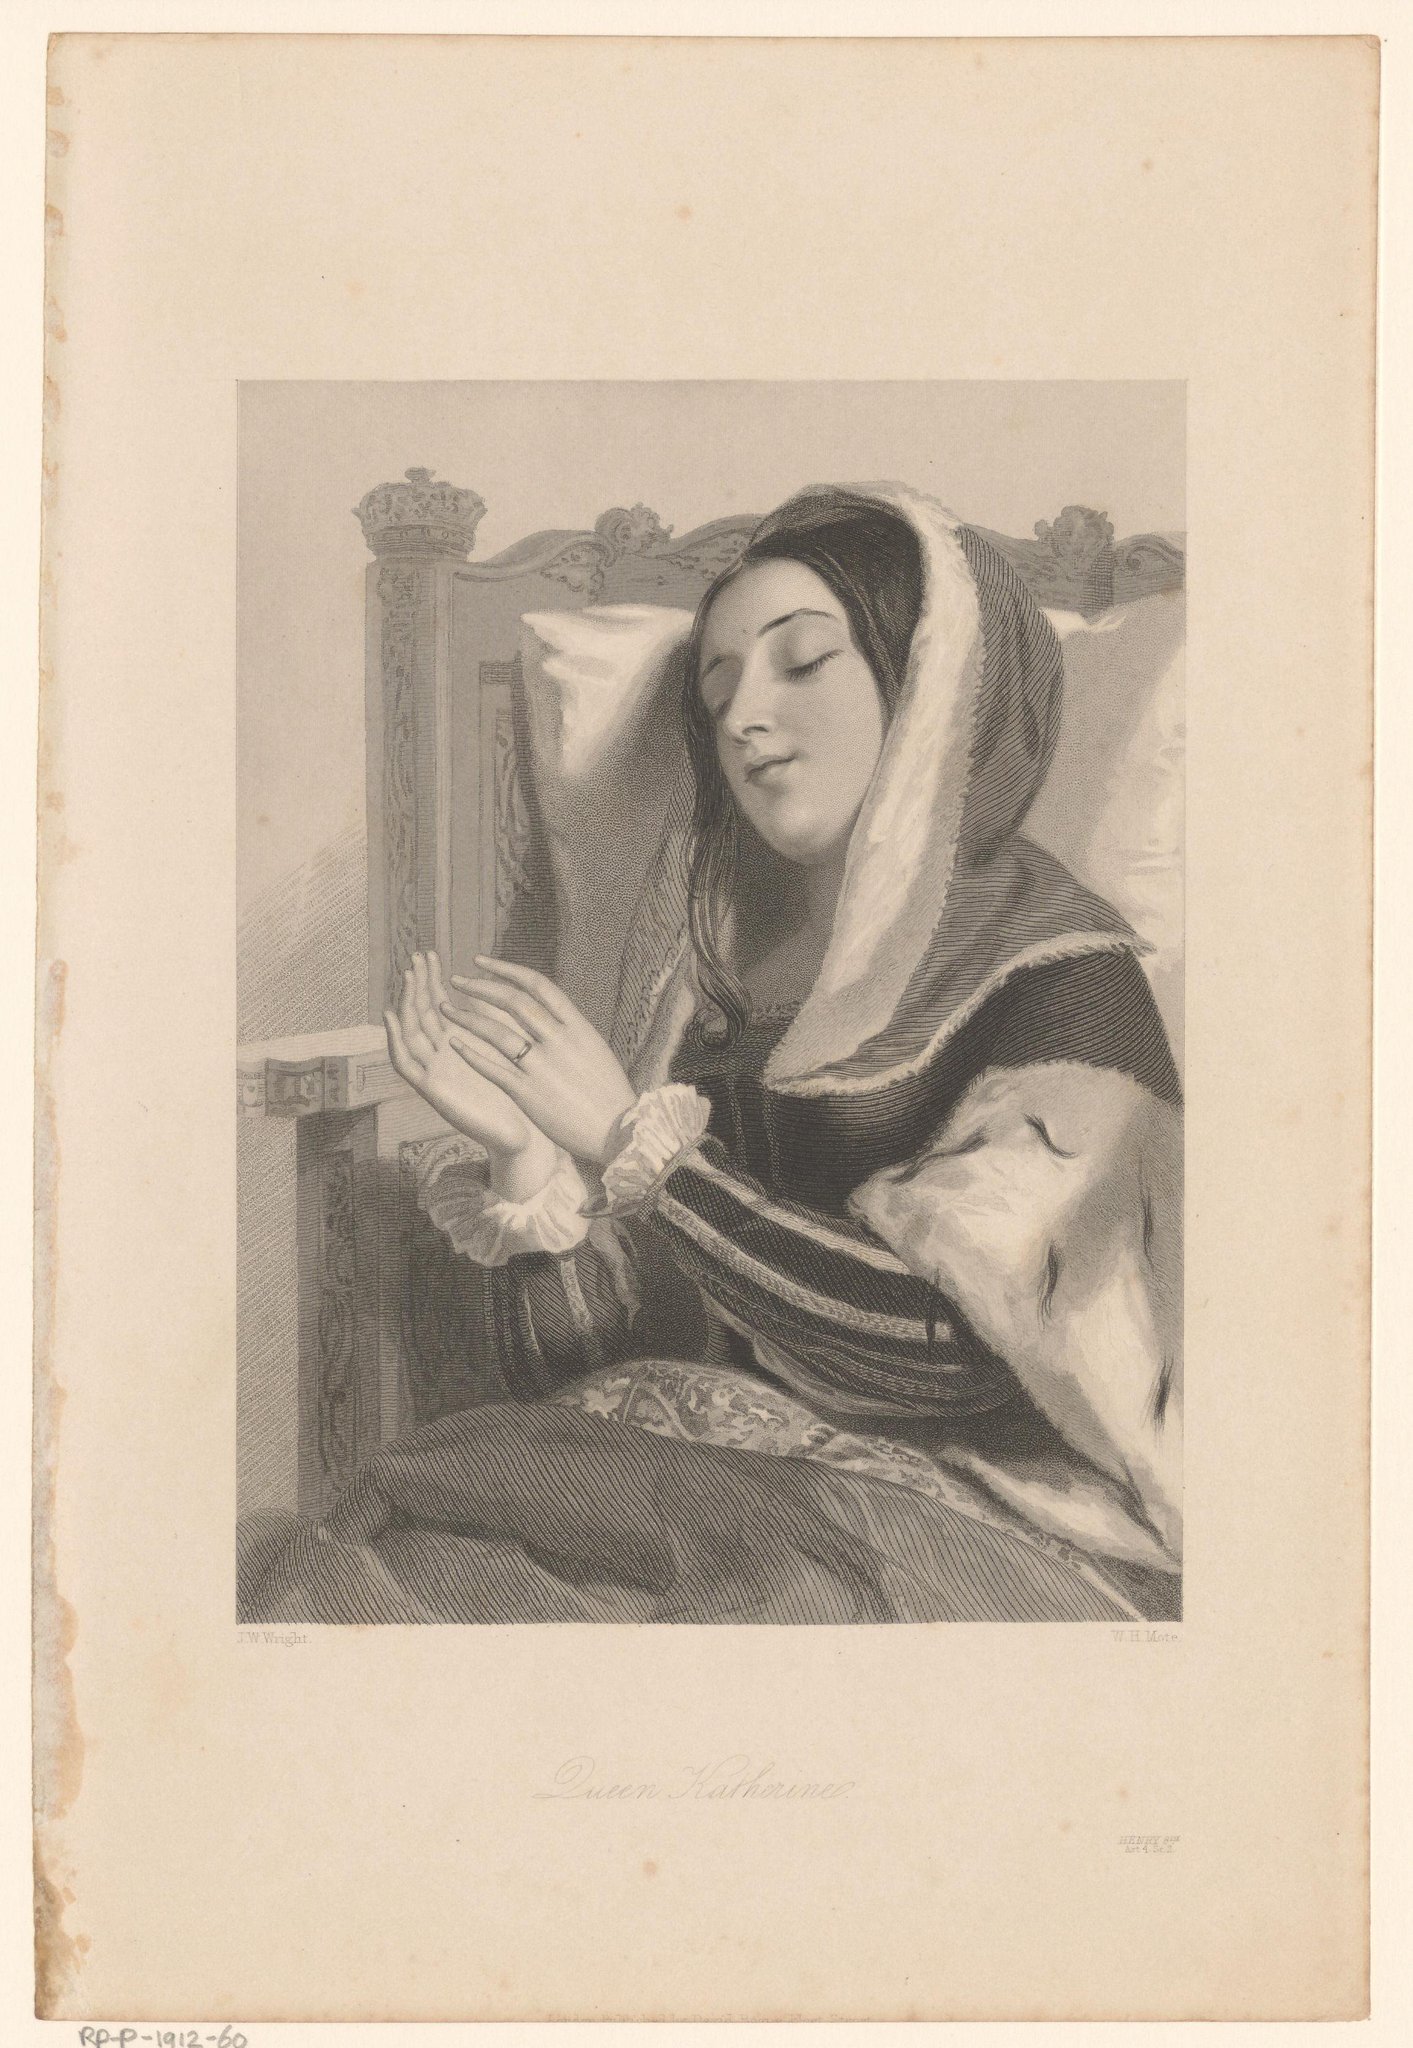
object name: print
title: Koningin Katherine, uit Shakespeares Hendrik VIII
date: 1846-1848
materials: paper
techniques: etching, roulette, engraving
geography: london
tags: william shakespeare, female literary characters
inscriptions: collector's mark: Lugt 2228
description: Prent ook gebruikt in: Heath, Charles. The heroines of Shakespeare: comprising the principal female characters in the plays of the great poet. Londen: David Bogue, 1848.